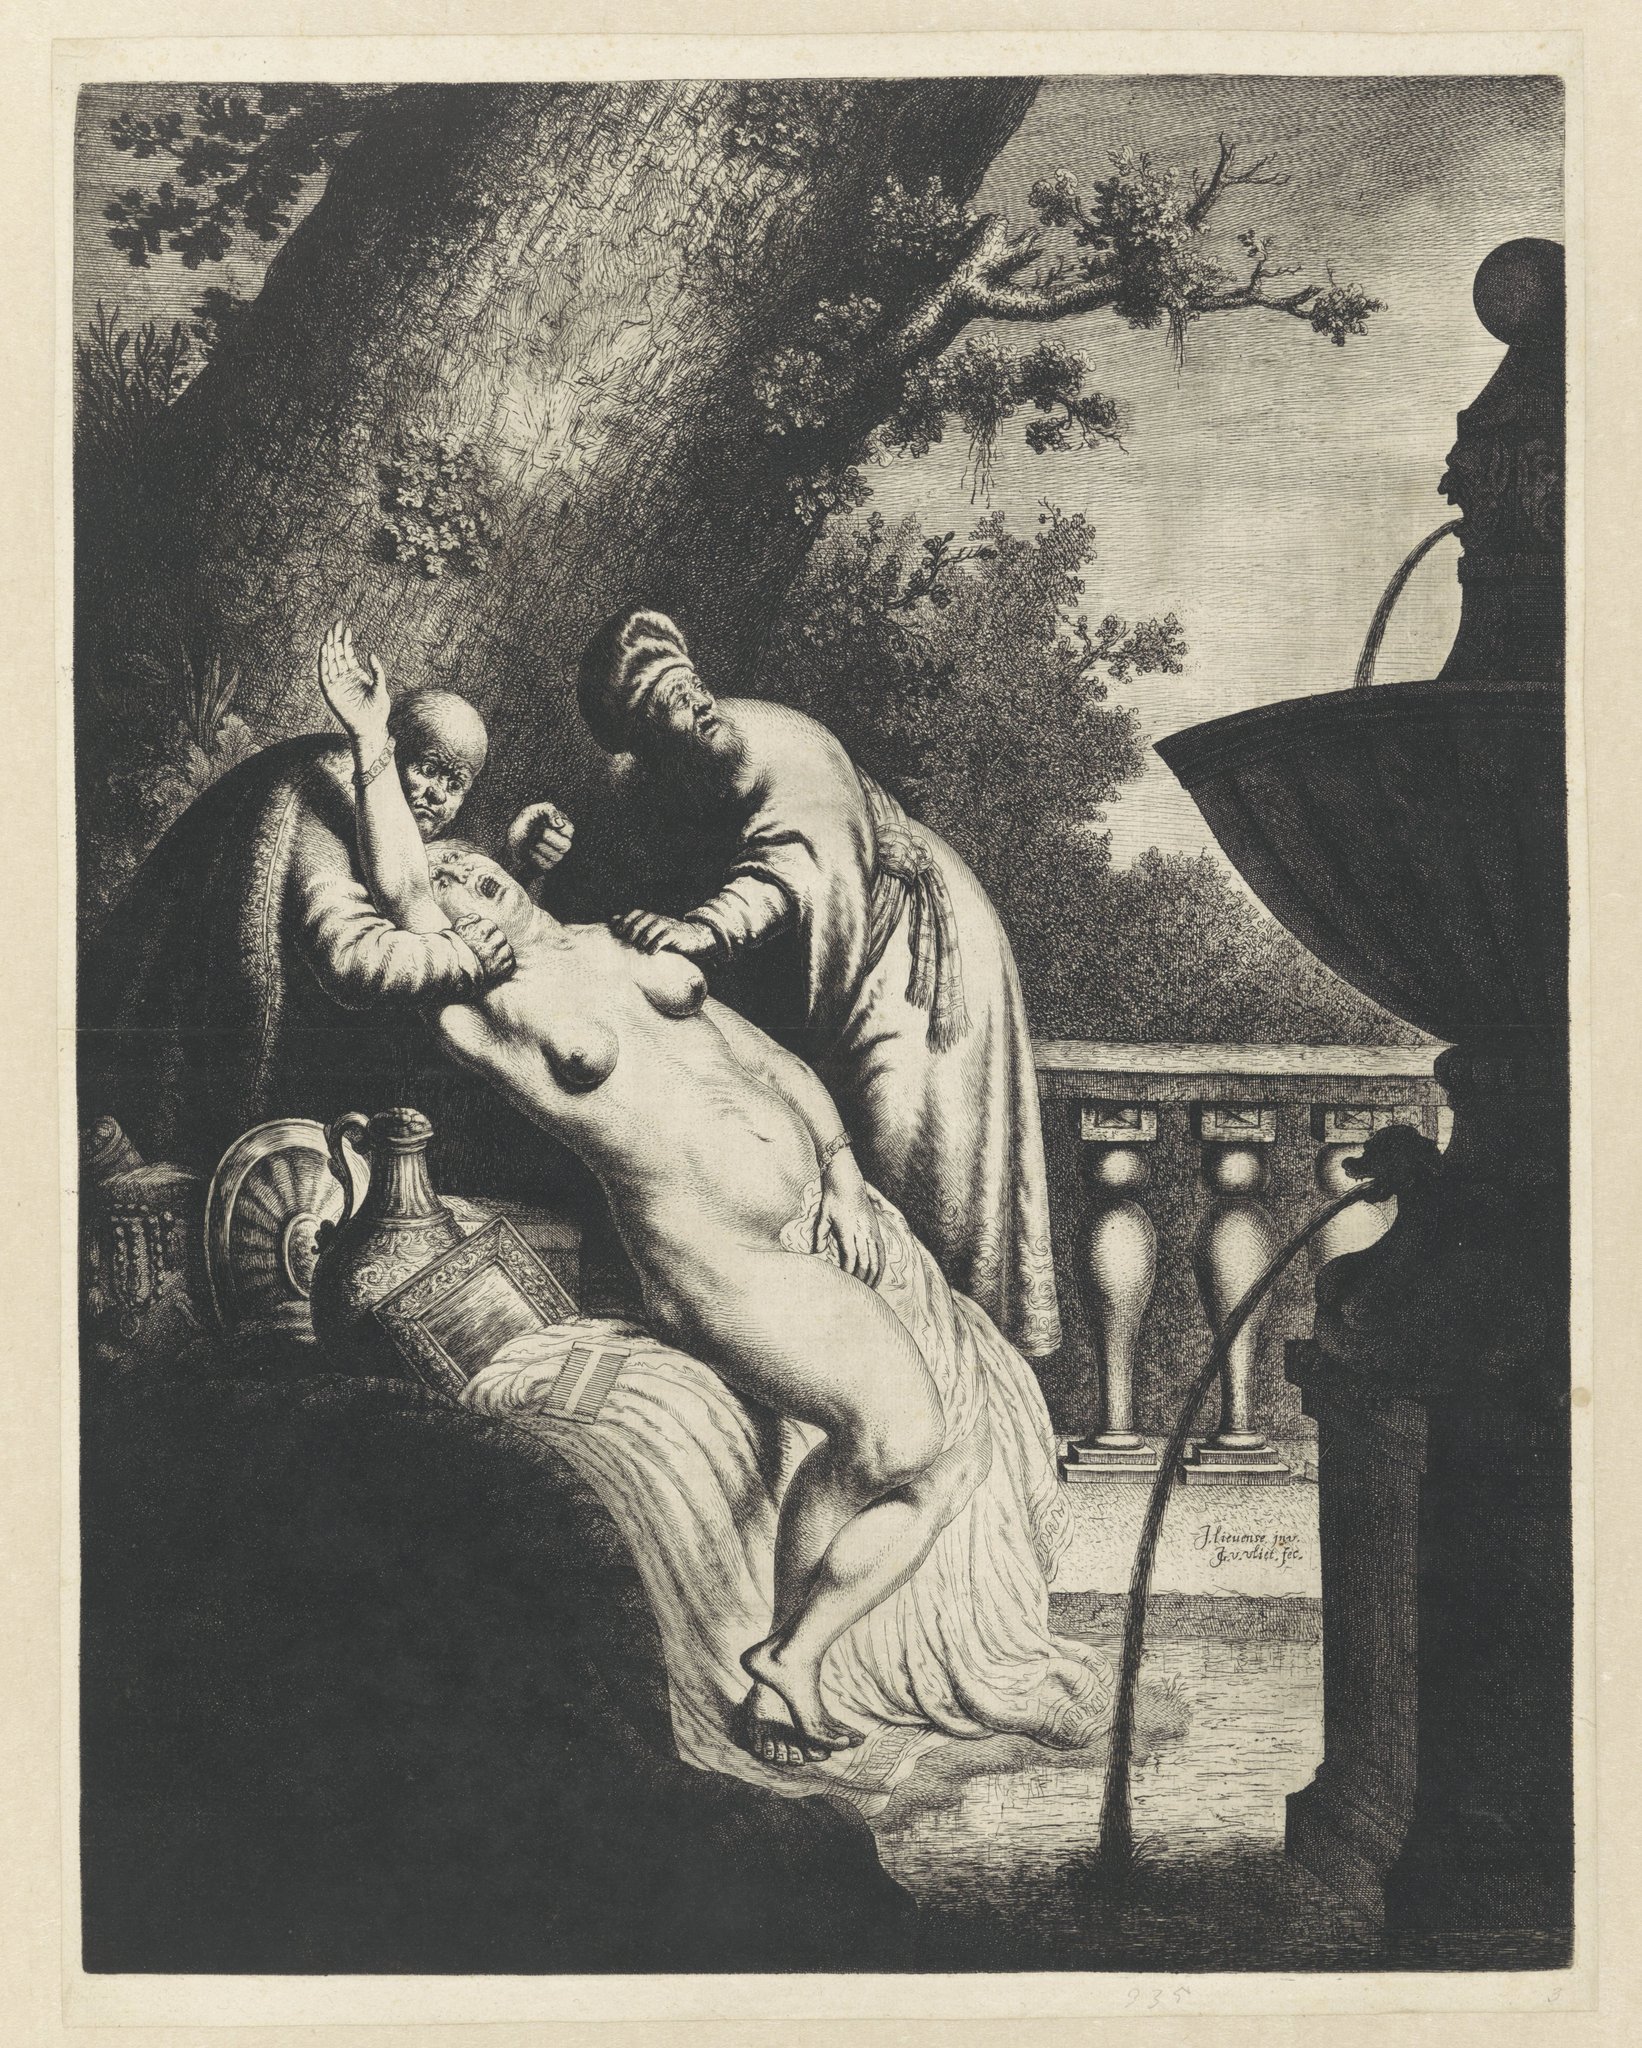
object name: print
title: Suzanna en de ouderlingen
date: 1632-1636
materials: paper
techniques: engraving, etching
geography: leiden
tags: susanna bathing, usually in or near a fountain and sometimes accompanied by two female servants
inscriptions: collector's mark: Lugt 240